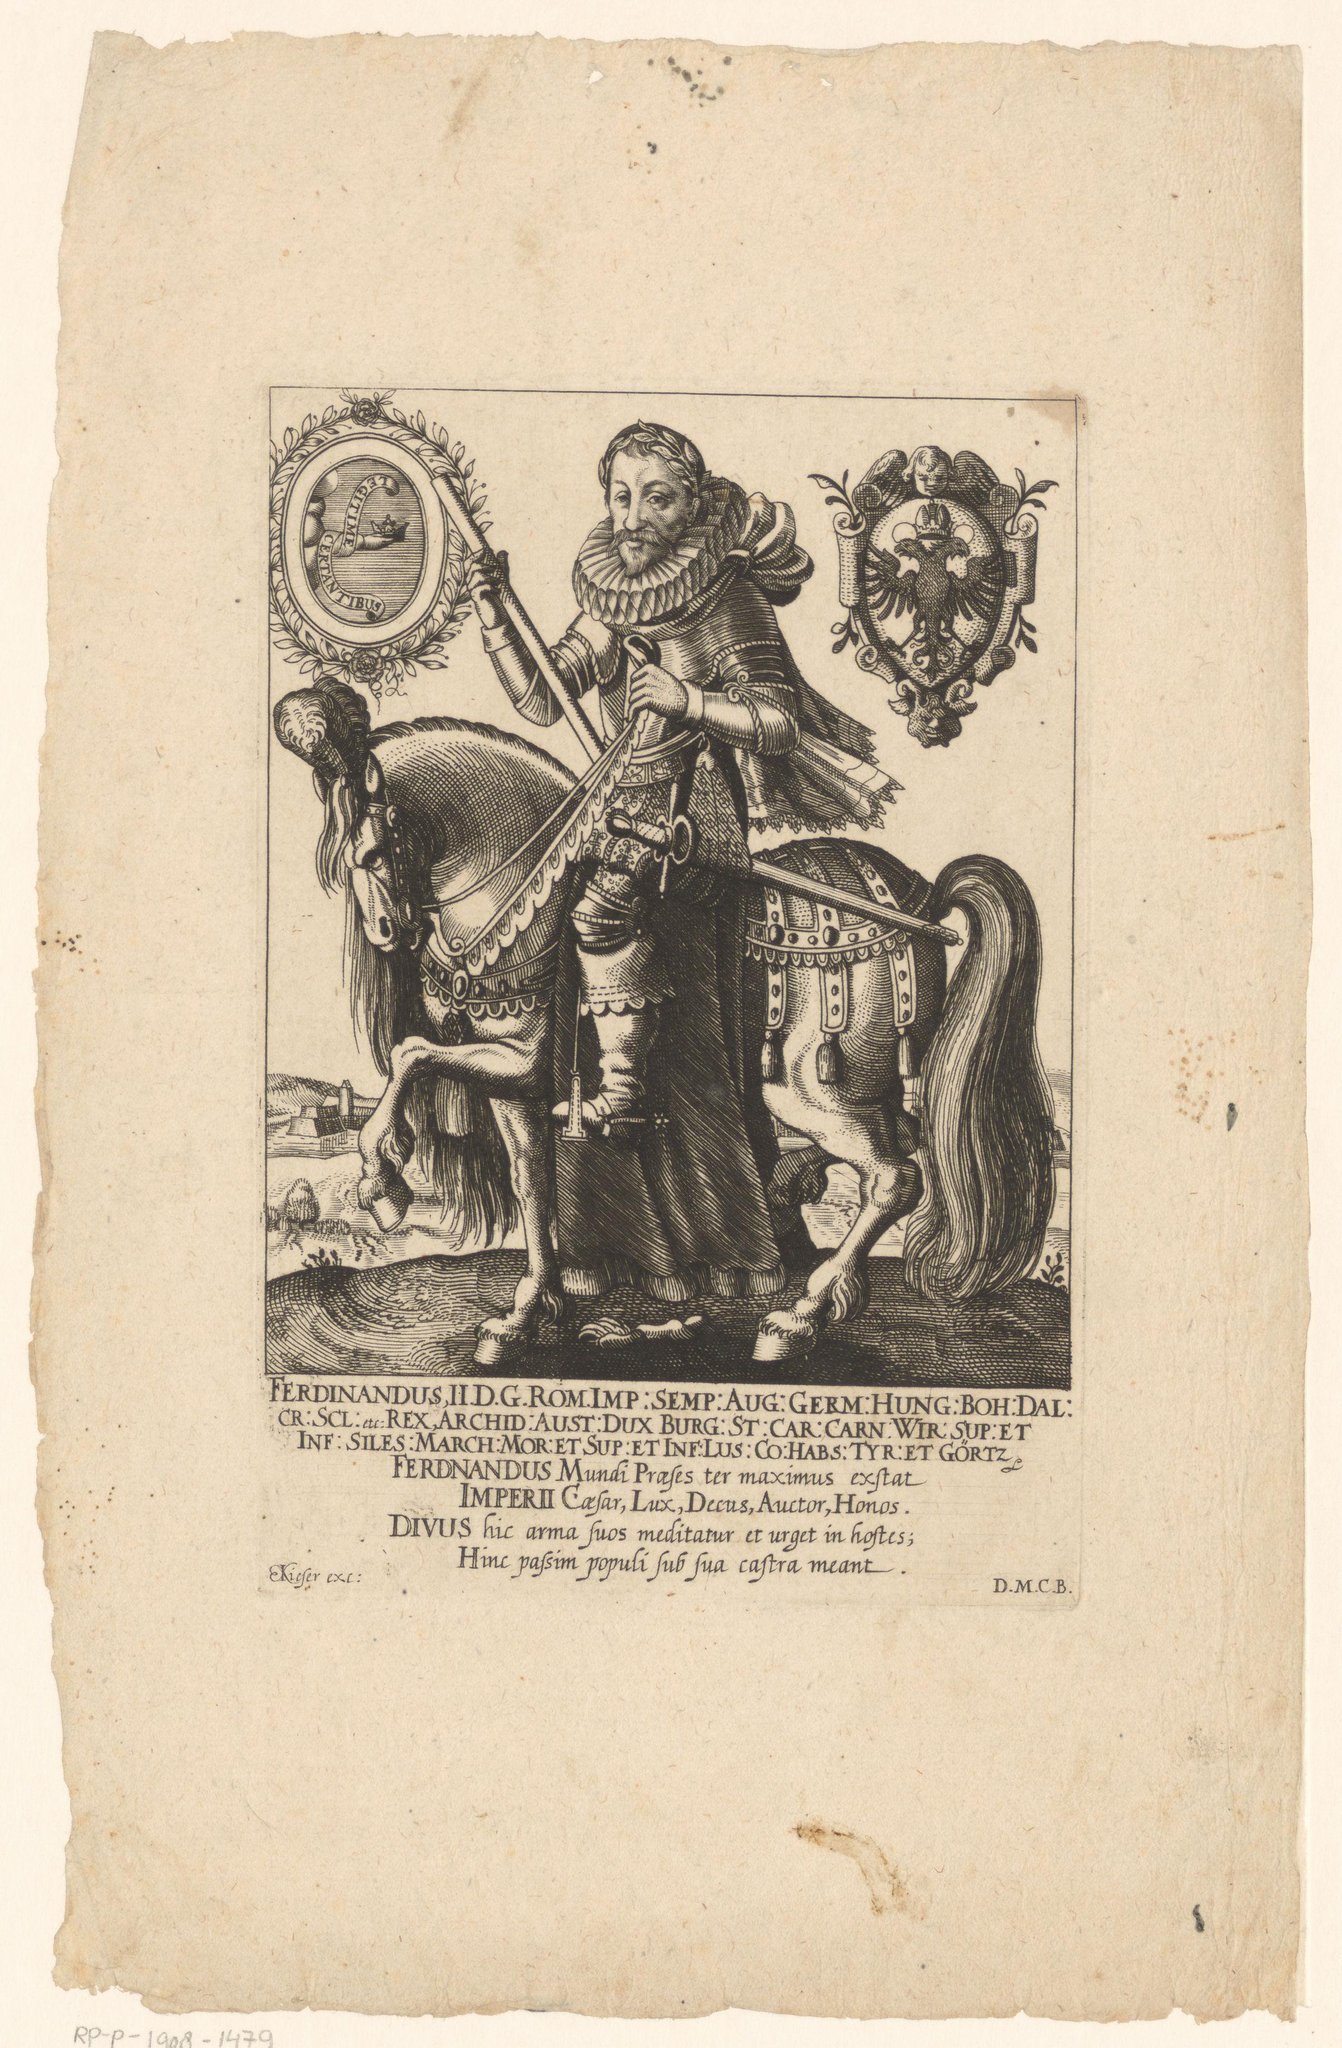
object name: print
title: Portret van Ferdinand II te paard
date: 1593-1625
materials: paper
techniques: engraving, etching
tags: ferdinand ii (duits keizer), commander-in-chief, general, marshal, historical persons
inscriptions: collector's mark: Lugt 2228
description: Daniel Meisner's signatuur eindigt met zijn geboortestad Chomutov (Komotau) in Bohemen, en wordt vaak genoteerd als D.M.C.B.